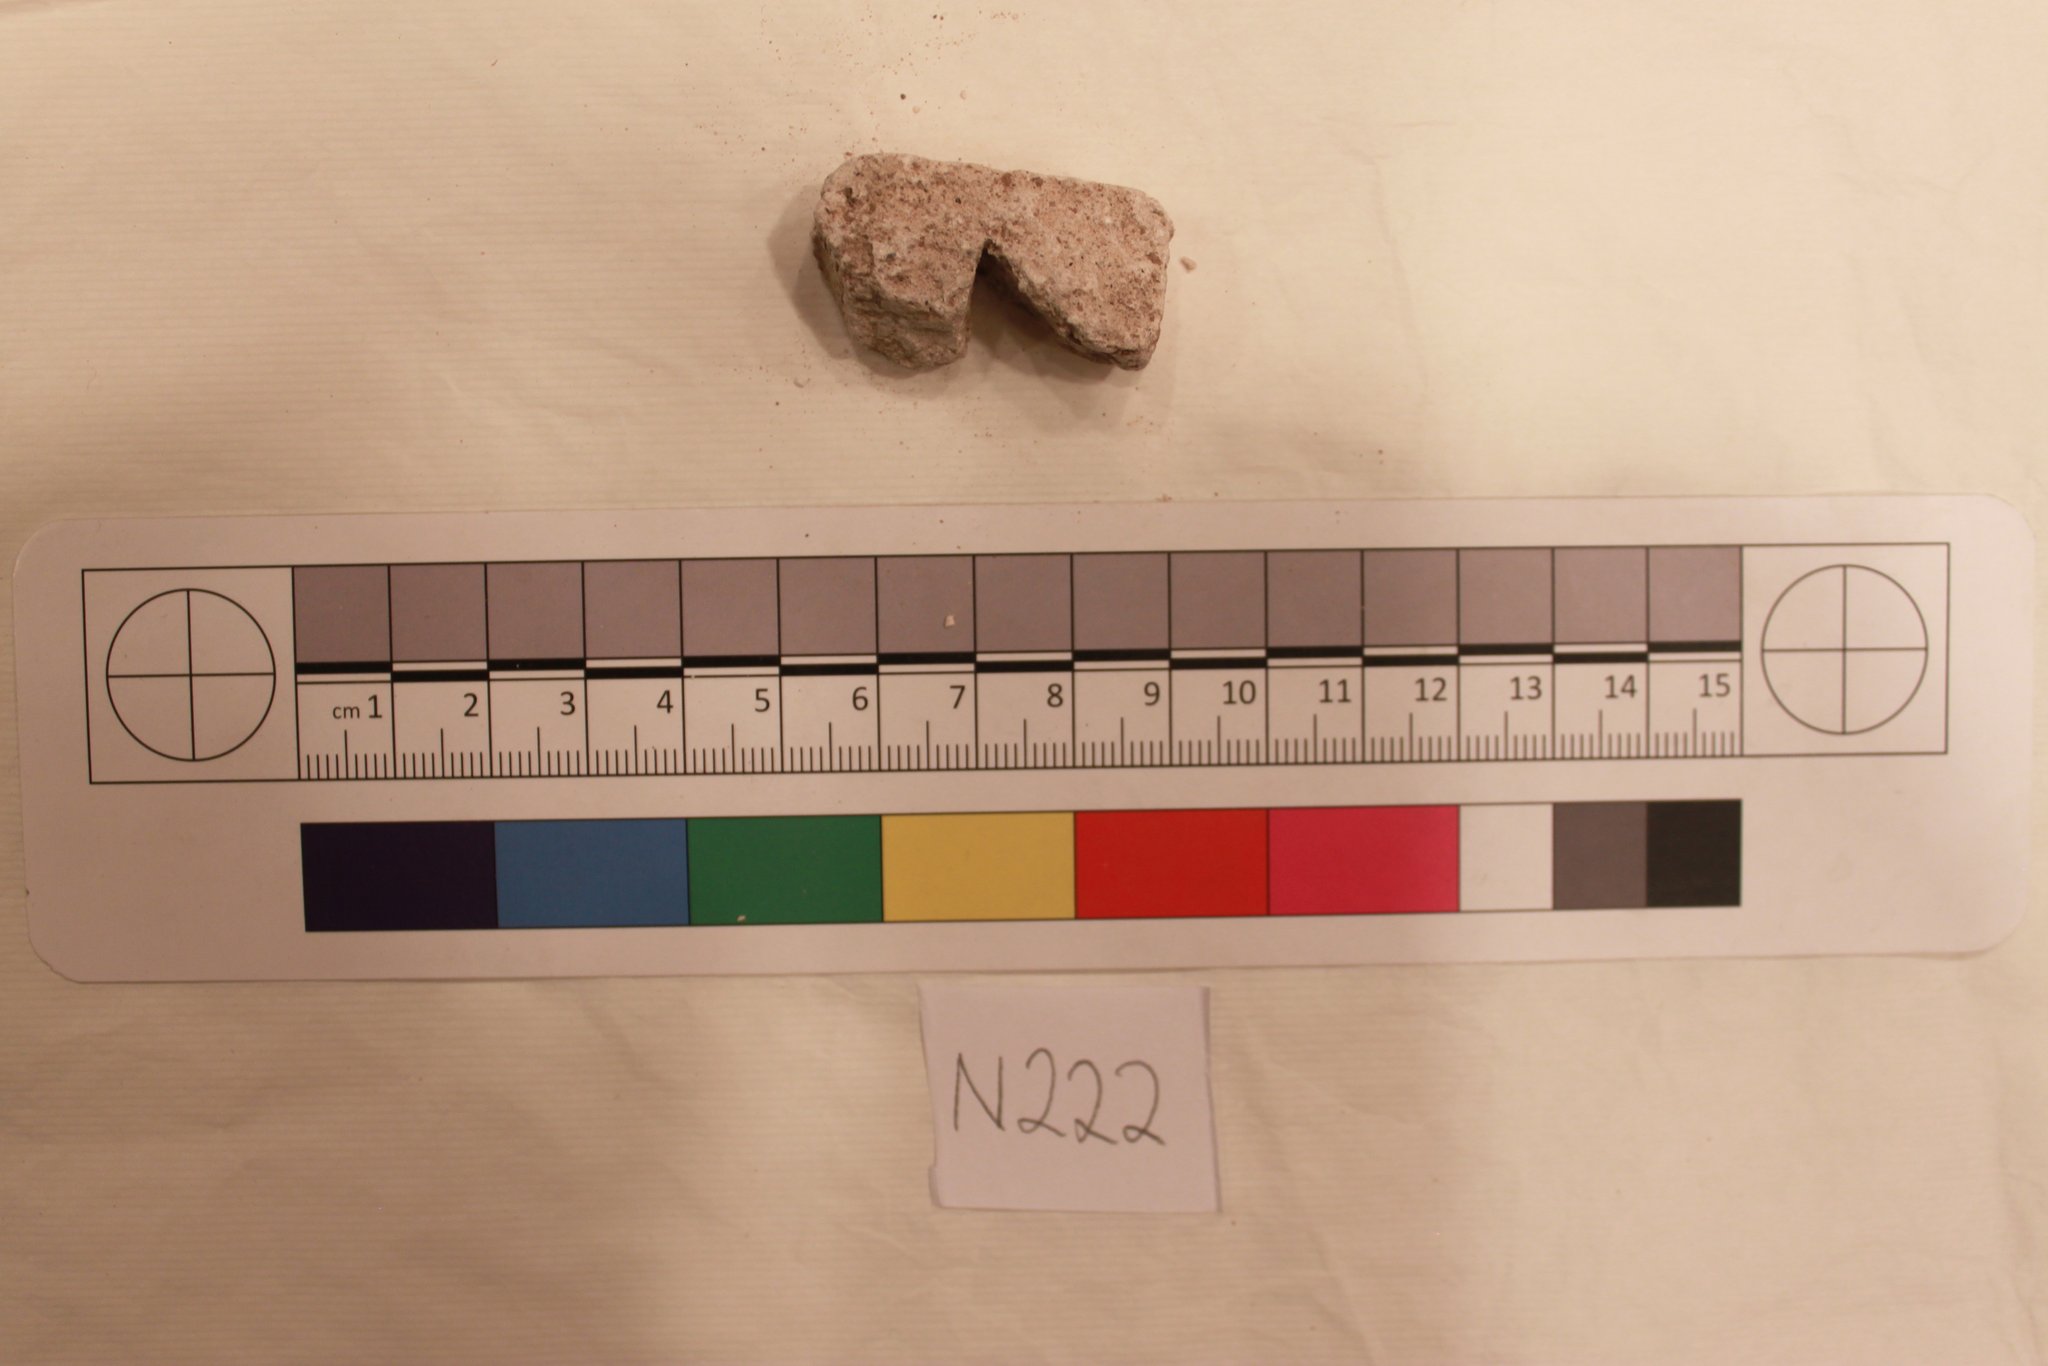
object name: fragment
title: Stucco Fragment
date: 701-1200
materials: plaster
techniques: carving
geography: iran